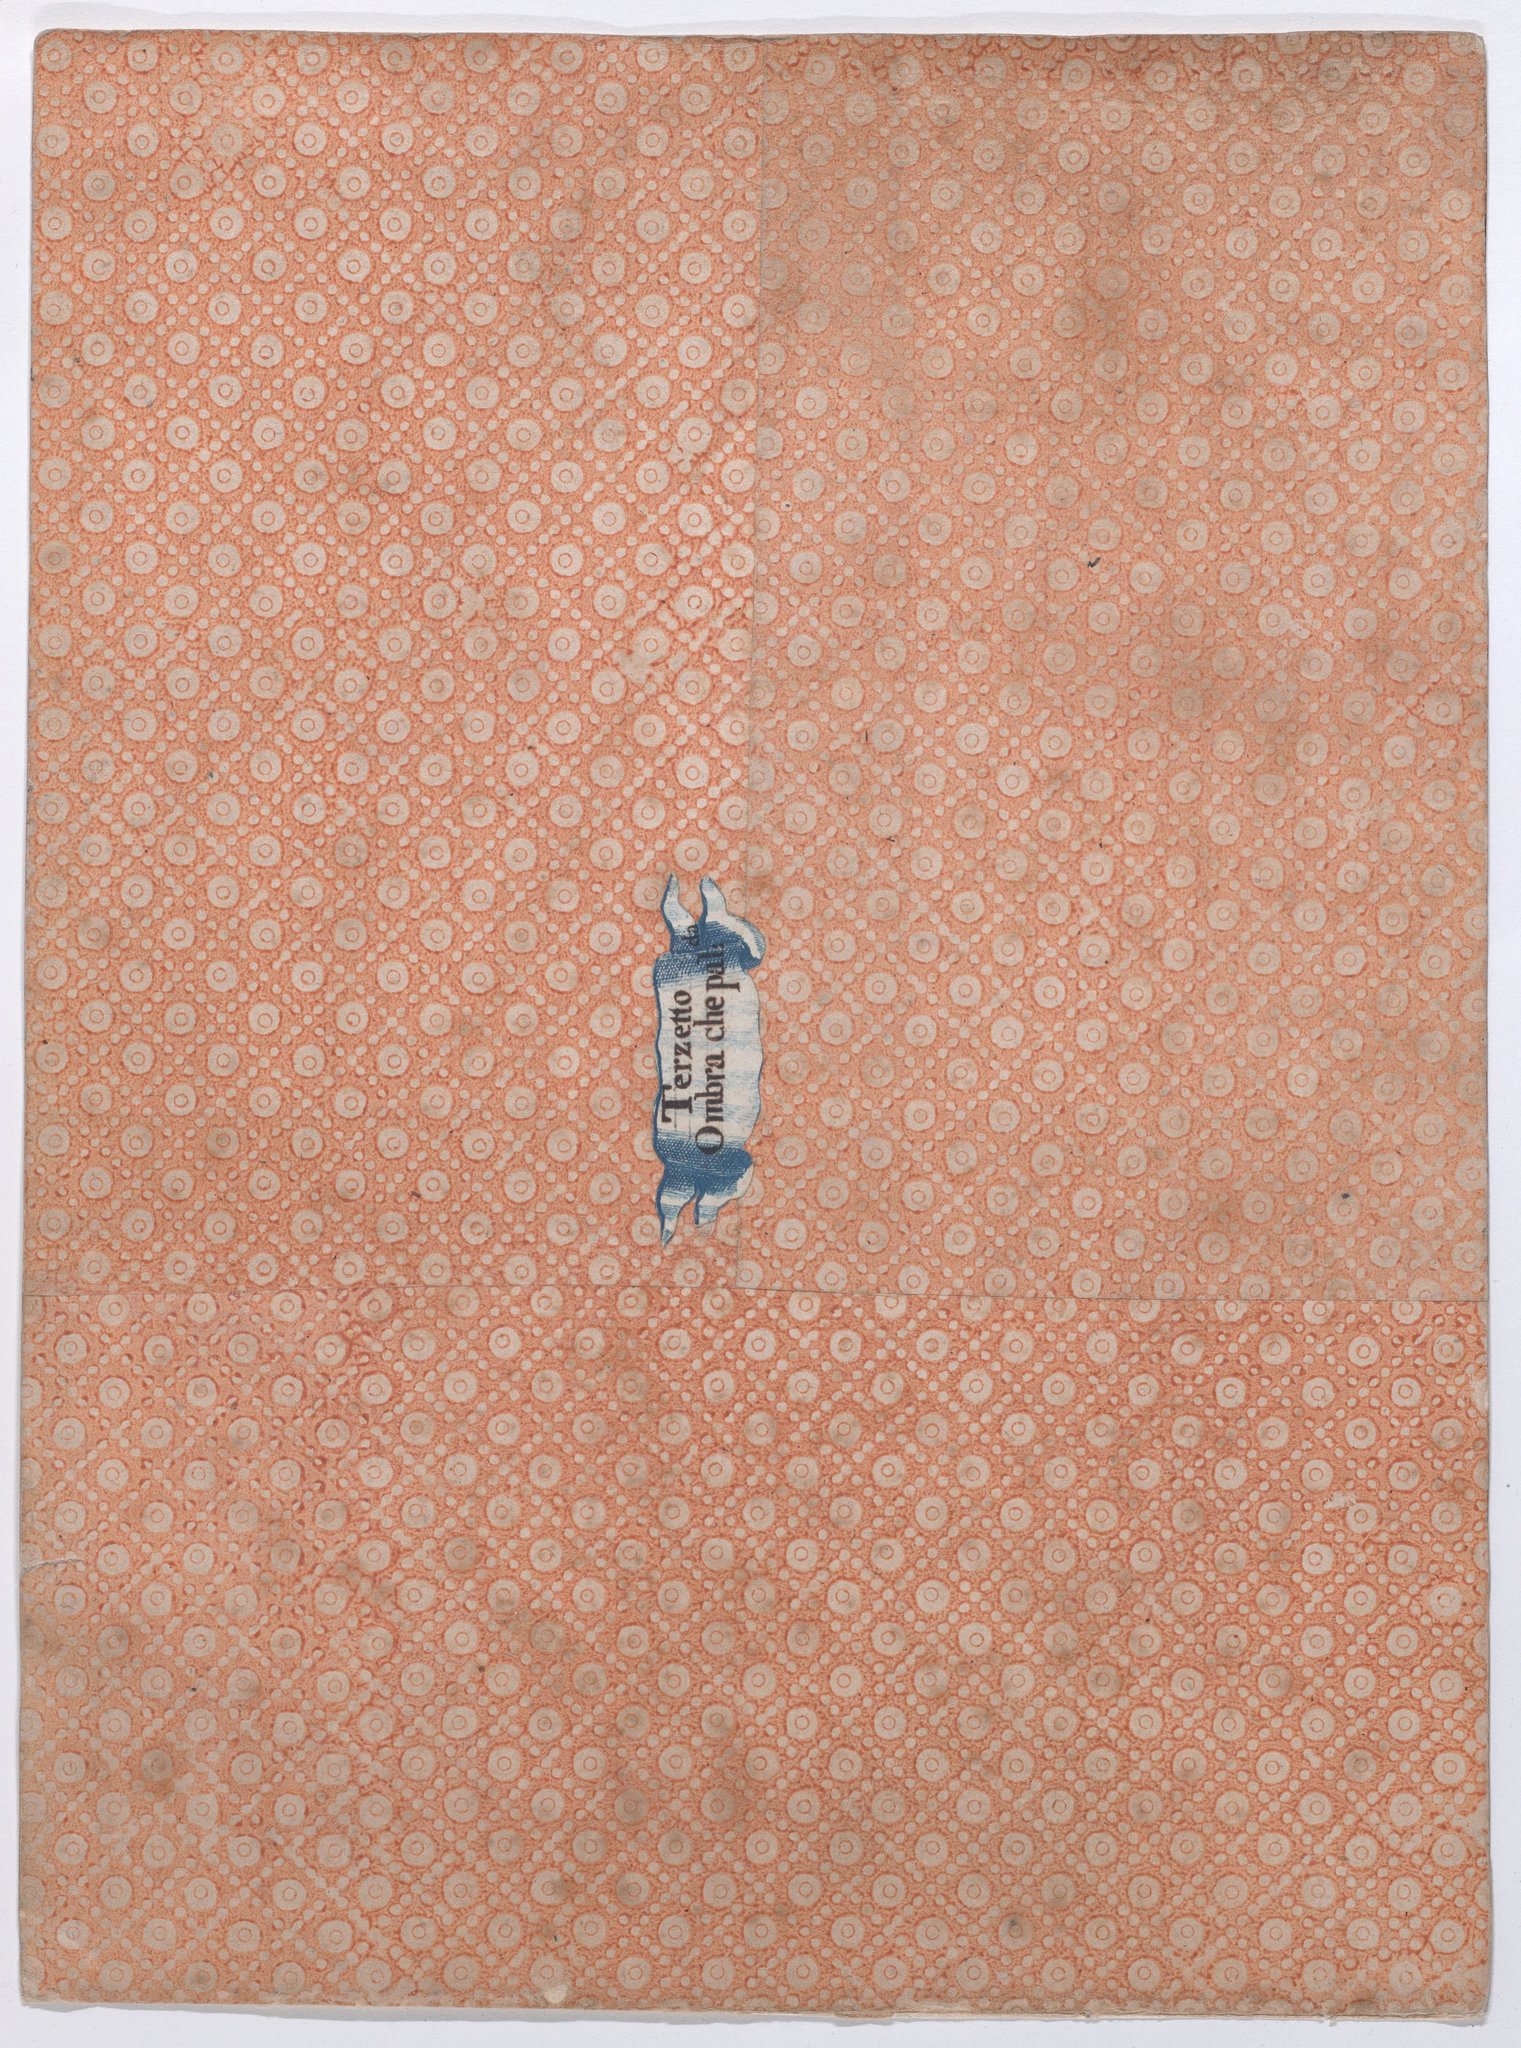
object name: print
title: Sheet with overall dot and circle pattern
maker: Anonymous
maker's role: artist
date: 1801-1900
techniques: relief print